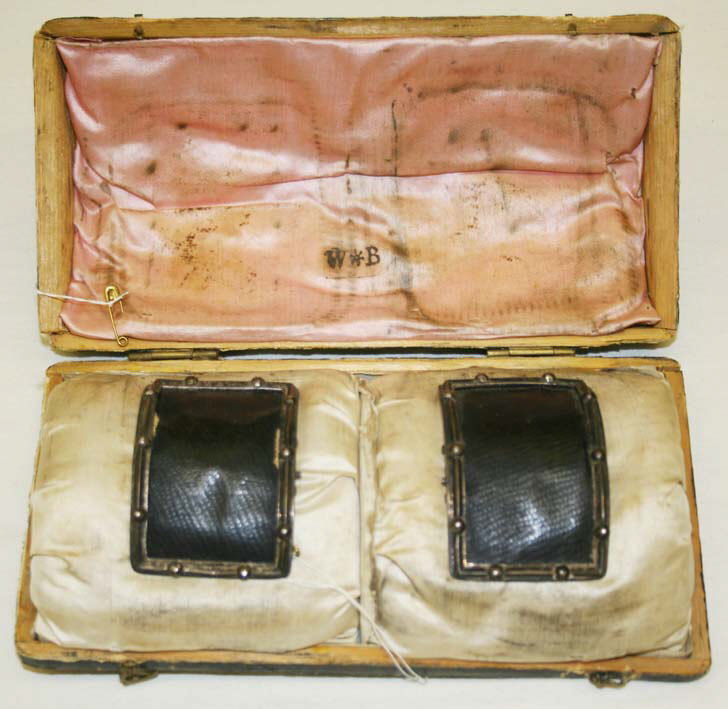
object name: shoe buckle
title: Shoe buckles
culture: british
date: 1791-1798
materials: canvas, leather, metal, silver